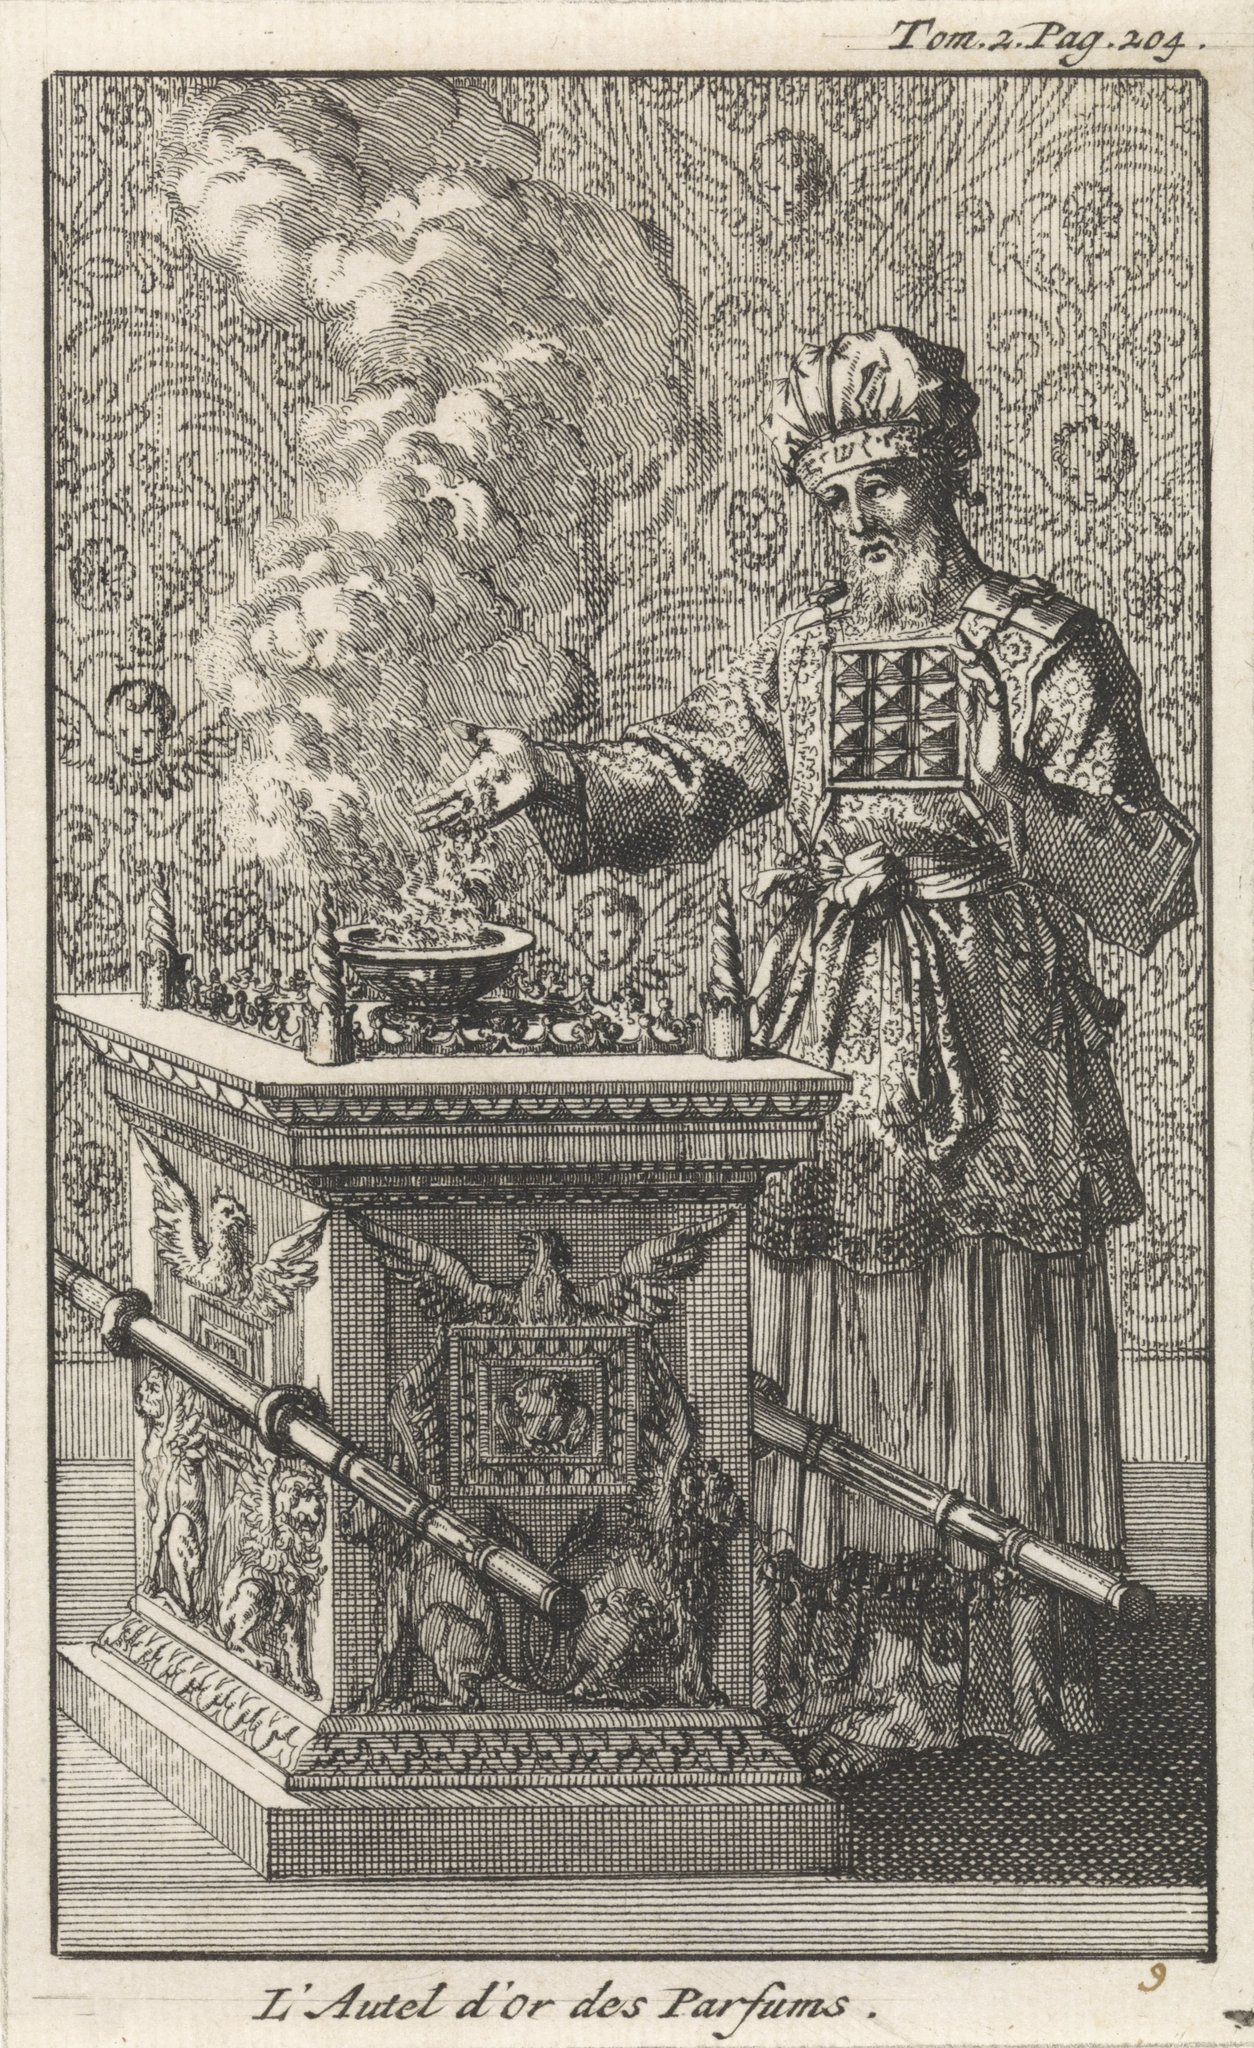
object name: book illustration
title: Gouden reukaltaar uit de Joodse eredienst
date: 1705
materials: paper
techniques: etching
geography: amsterdam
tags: the altar of incense, the golden altar ~ jewish religion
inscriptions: number: ‘9’, collector's mark: Lugt 2228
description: Illustratie uit: Cunaeus, Petrus. La republique des Hebreux, 3 delen. Amsterdam: Pieter Mortier, 1705, dl. II, p. 204.